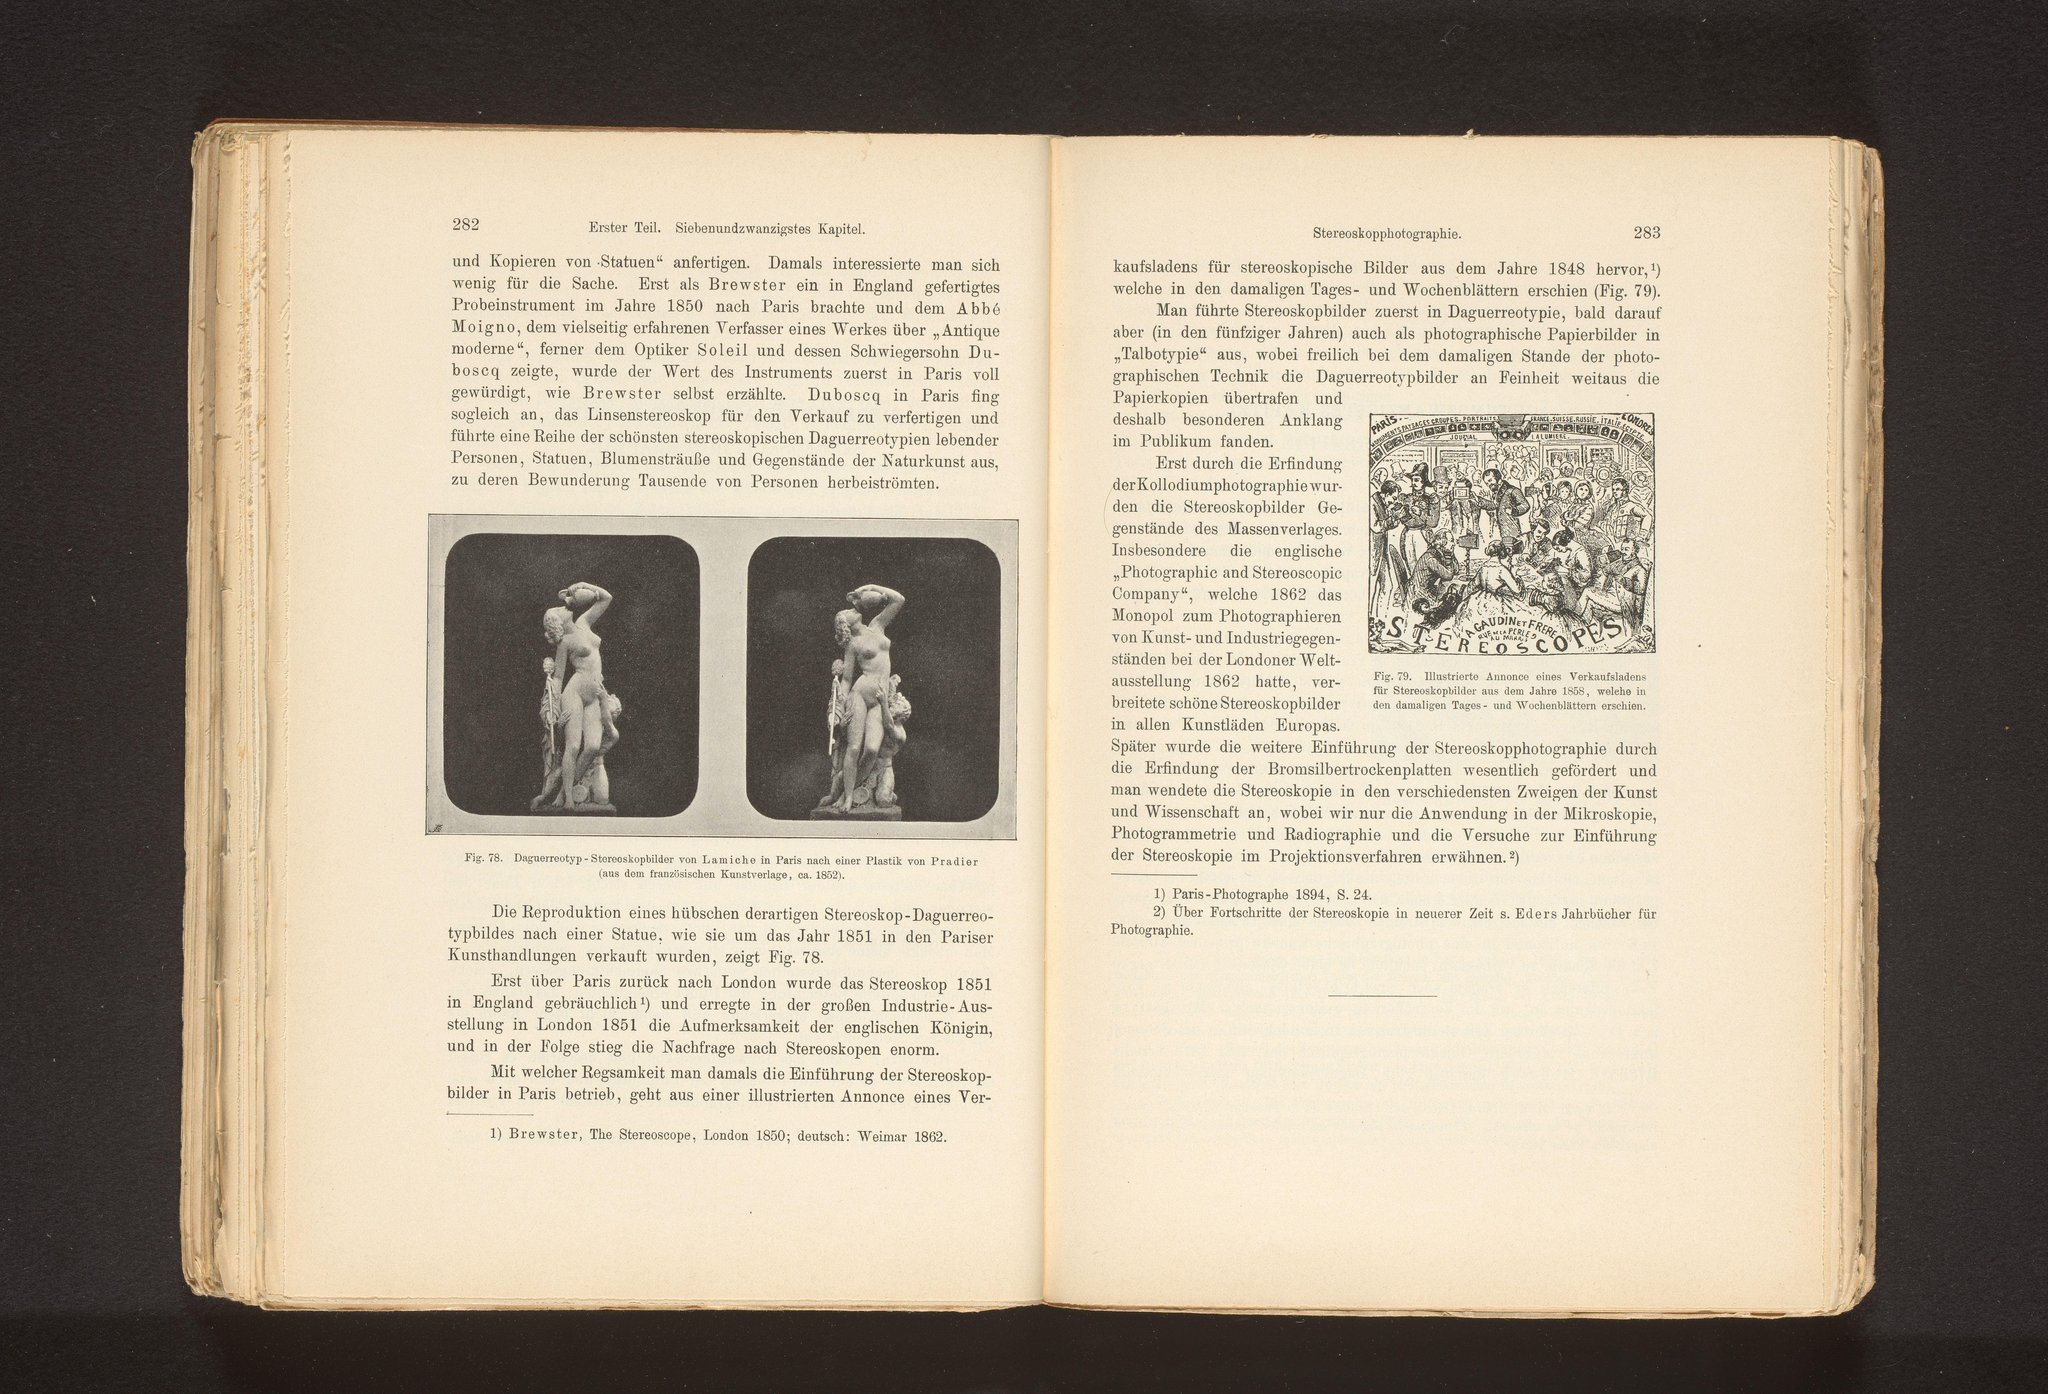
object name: page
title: Standbeeld, (vermoedelijk) voorstellende een sater en een mainade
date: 1900-1905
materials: paper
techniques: autotype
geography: paris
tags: maenad(s), female bacchant(es), satyr(s) (in general), sculpture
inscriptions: number: ‘Fig. 78.’, inscription: ‘Daguerreotyp-Stereoscopbilder (...) ca. 1892)’